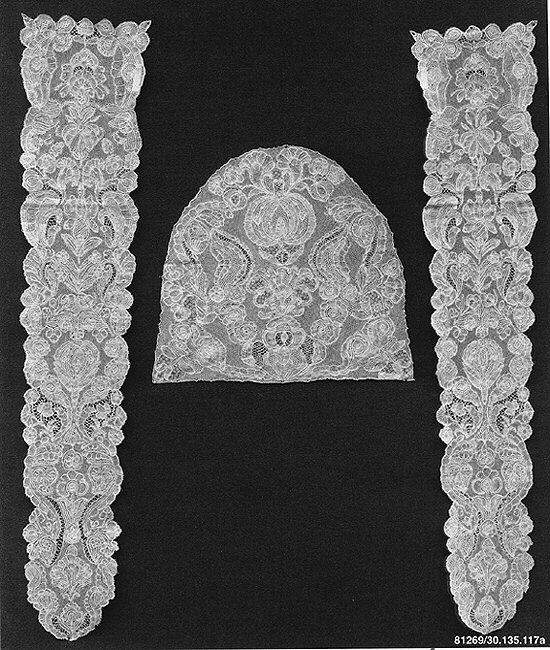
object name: cap crown and lappet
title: Cap crown and pair of lappets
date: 1720-1740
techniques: lace